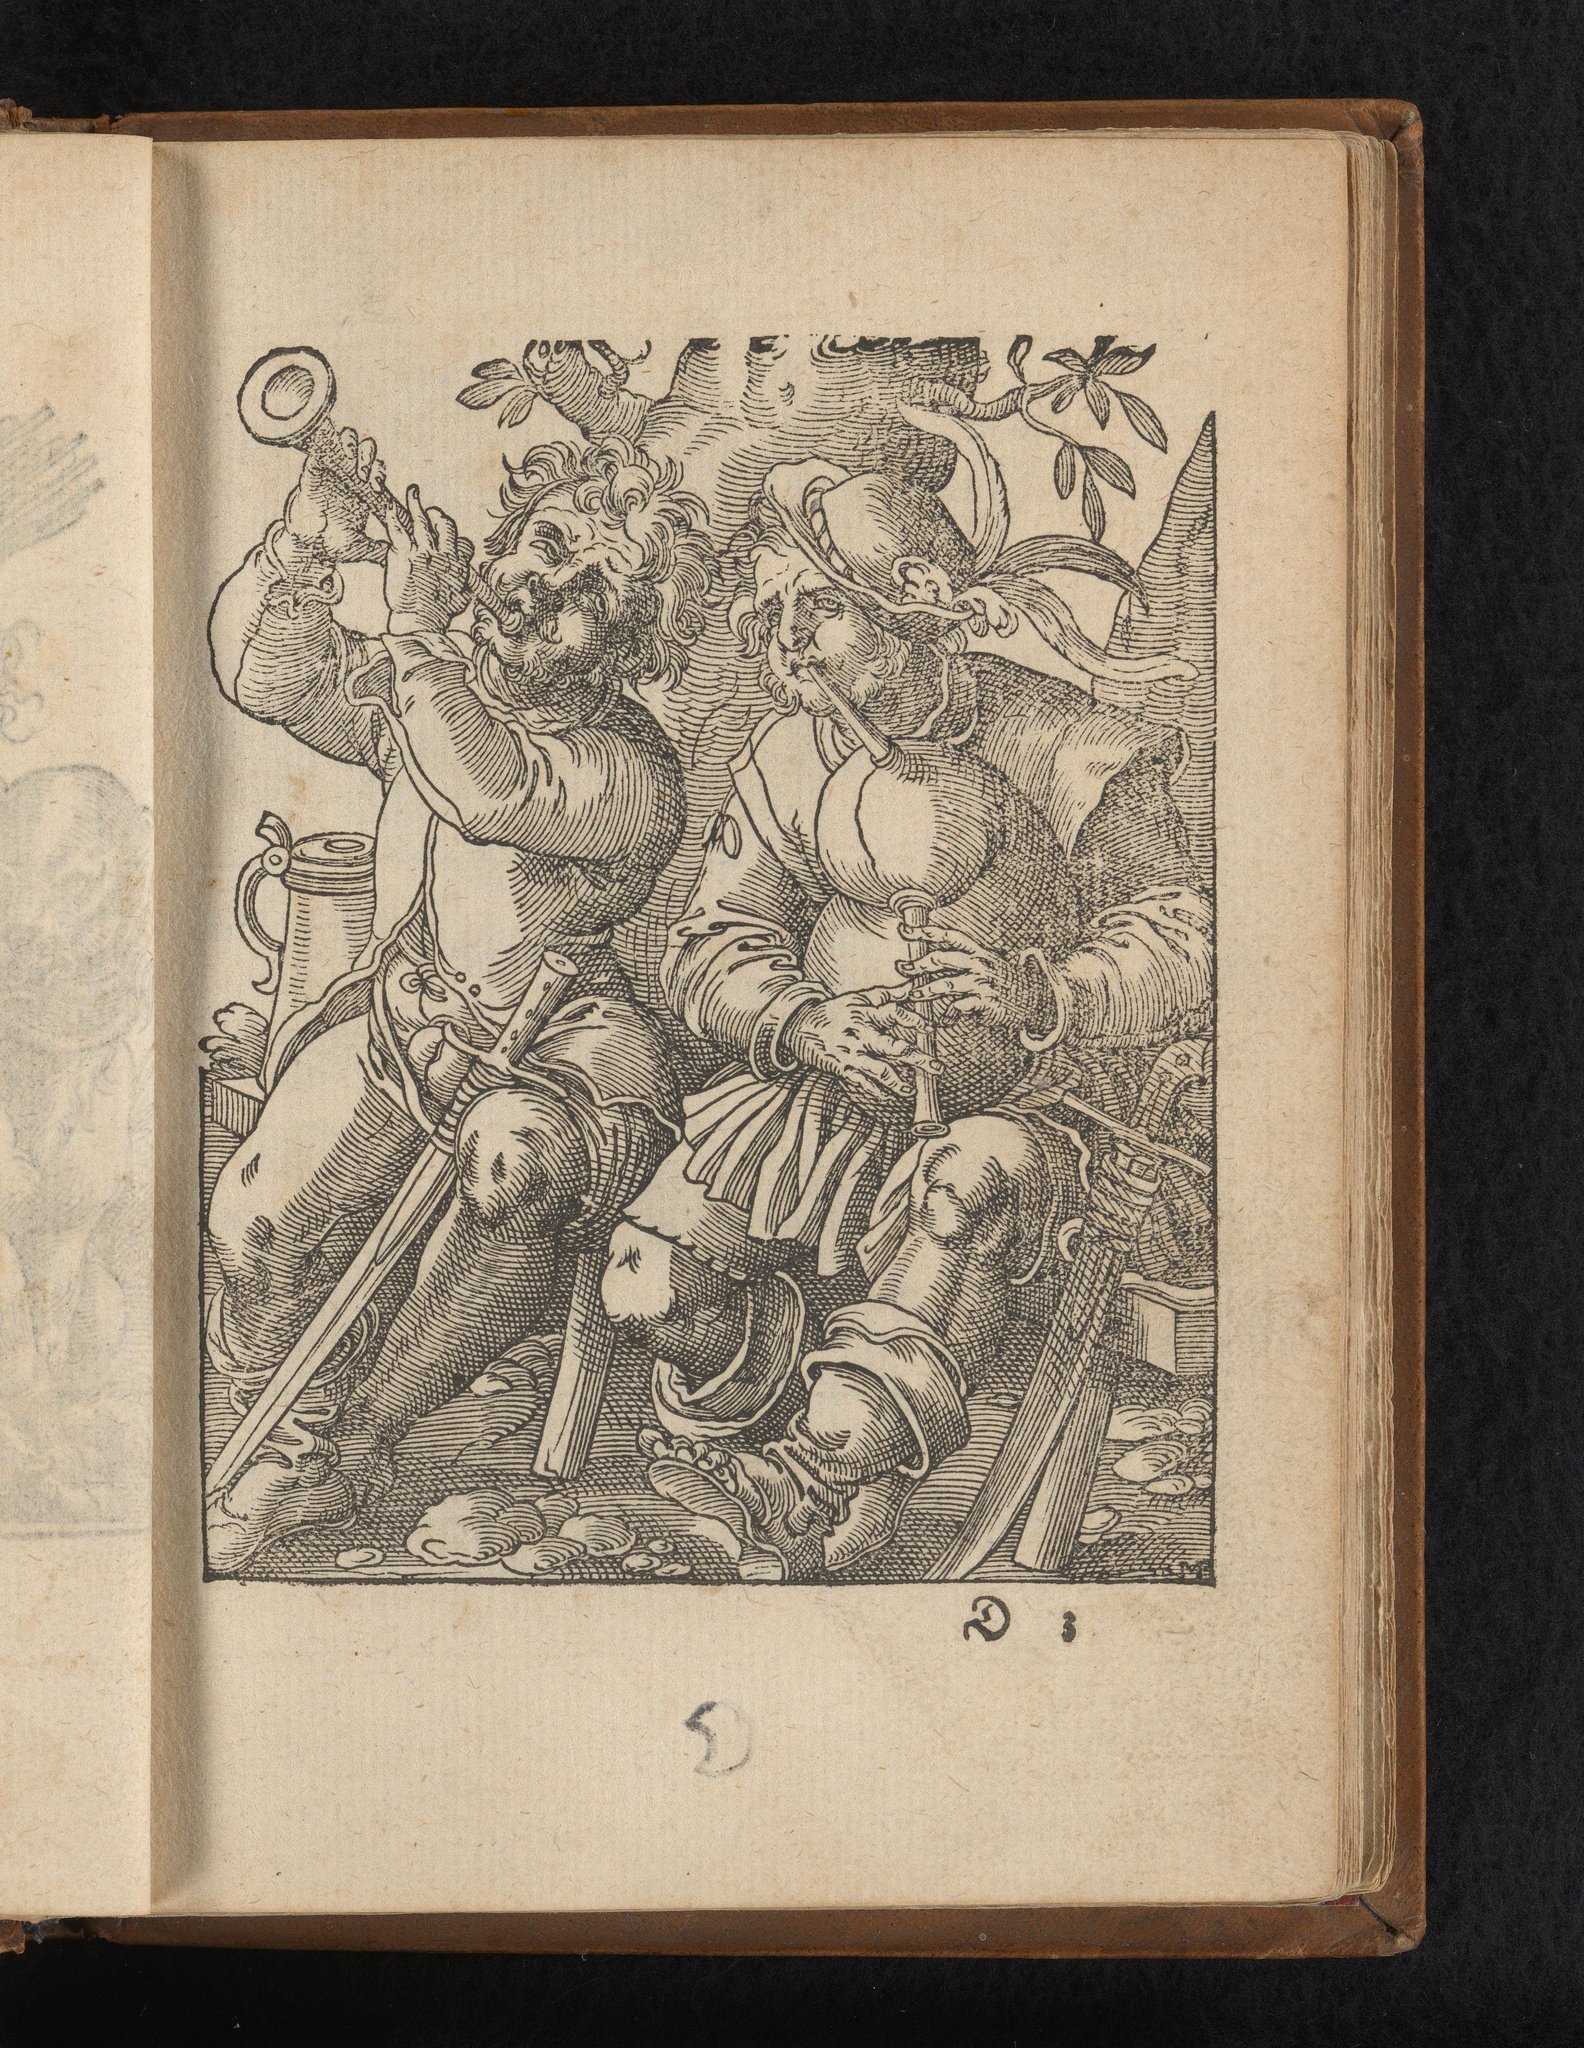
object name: print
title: Schalmeispeler en een doedelzakspeler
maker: monogrammist mf (duitsland)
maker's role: houtsnijder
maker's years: 1550-1599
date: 1578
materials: paper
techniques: woodcut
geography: nuremberg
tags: clarinet, bassoon, oboe, shawm - cc - out of doors, bagpipe, musette - cc - out of doors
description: Twee zittende mannen, een schalmeispeler en een doedelzakspeler. Onderdeel van het modelboek Enchiridion artis pingendi, fingendi & sculpendi met 108 figuren bedoeld voor beginnende schilders, beeldhouwers en prentmakers.